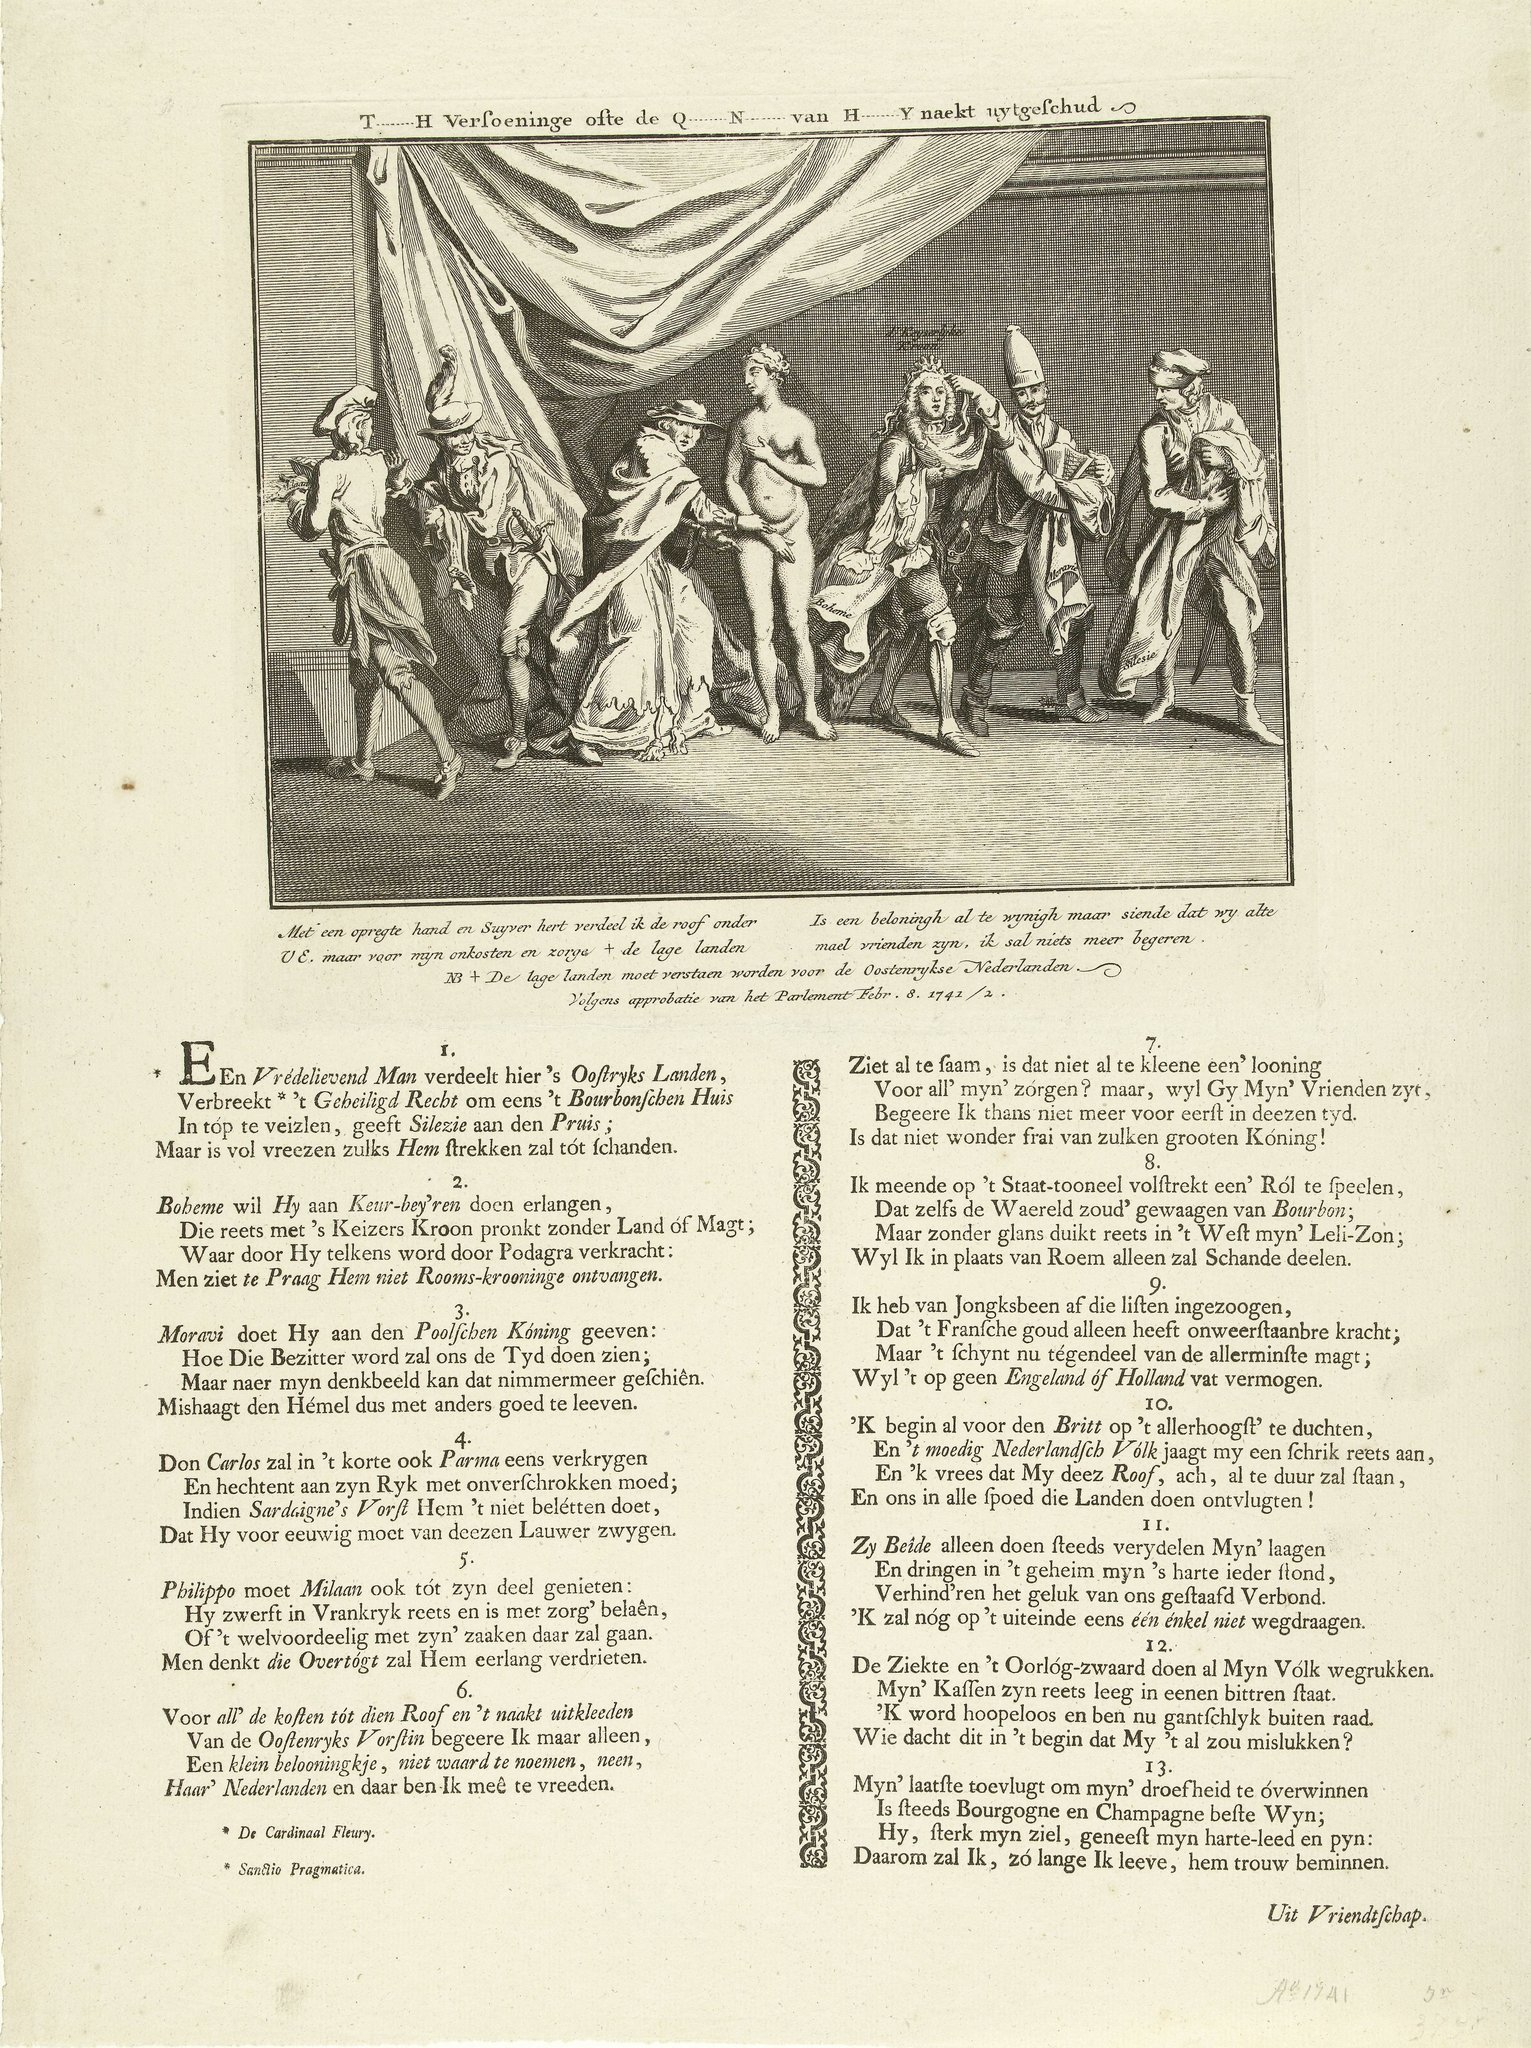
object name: cartoon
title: T (...)H Versoeninge ofte de Q (...)N (...) van H (...)Y naekt uytgeschud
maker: Anonymous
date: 1742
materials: paper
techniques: etching, letterpress printing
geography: northern netherlands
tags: france, vienna, maria theresia (rooms-duits keizerin), political caricatures and satires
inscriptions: collector's mark: Lugt 2228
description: Spotprent op de verdeling van de Oostenrijkse landen door kardinaal Fleury, 1742. De Oostenrijkse aartshertogin Maria Theresia staat geheel ontkleed, de rovers lopen met haar kledingstukken (Bohemen, Moravië, Silezië, Milaan en Parma) weg, de kardinaal probeert de hand weg te halen waarmee zij probeert haar schaamstreek (de lage landen = Oostenrijkse Nederlanden) bedekt te houden. In het onderschrift verklaart de kardinaal de Lage Landen, al is het een te armzalige beloning, zelf wel te willen nemen. Allegorie op de Oostenrijkse successieoorlog. Op het blad onder de plaat verklaring van de voorstelling in verzen genummerd 1-13.